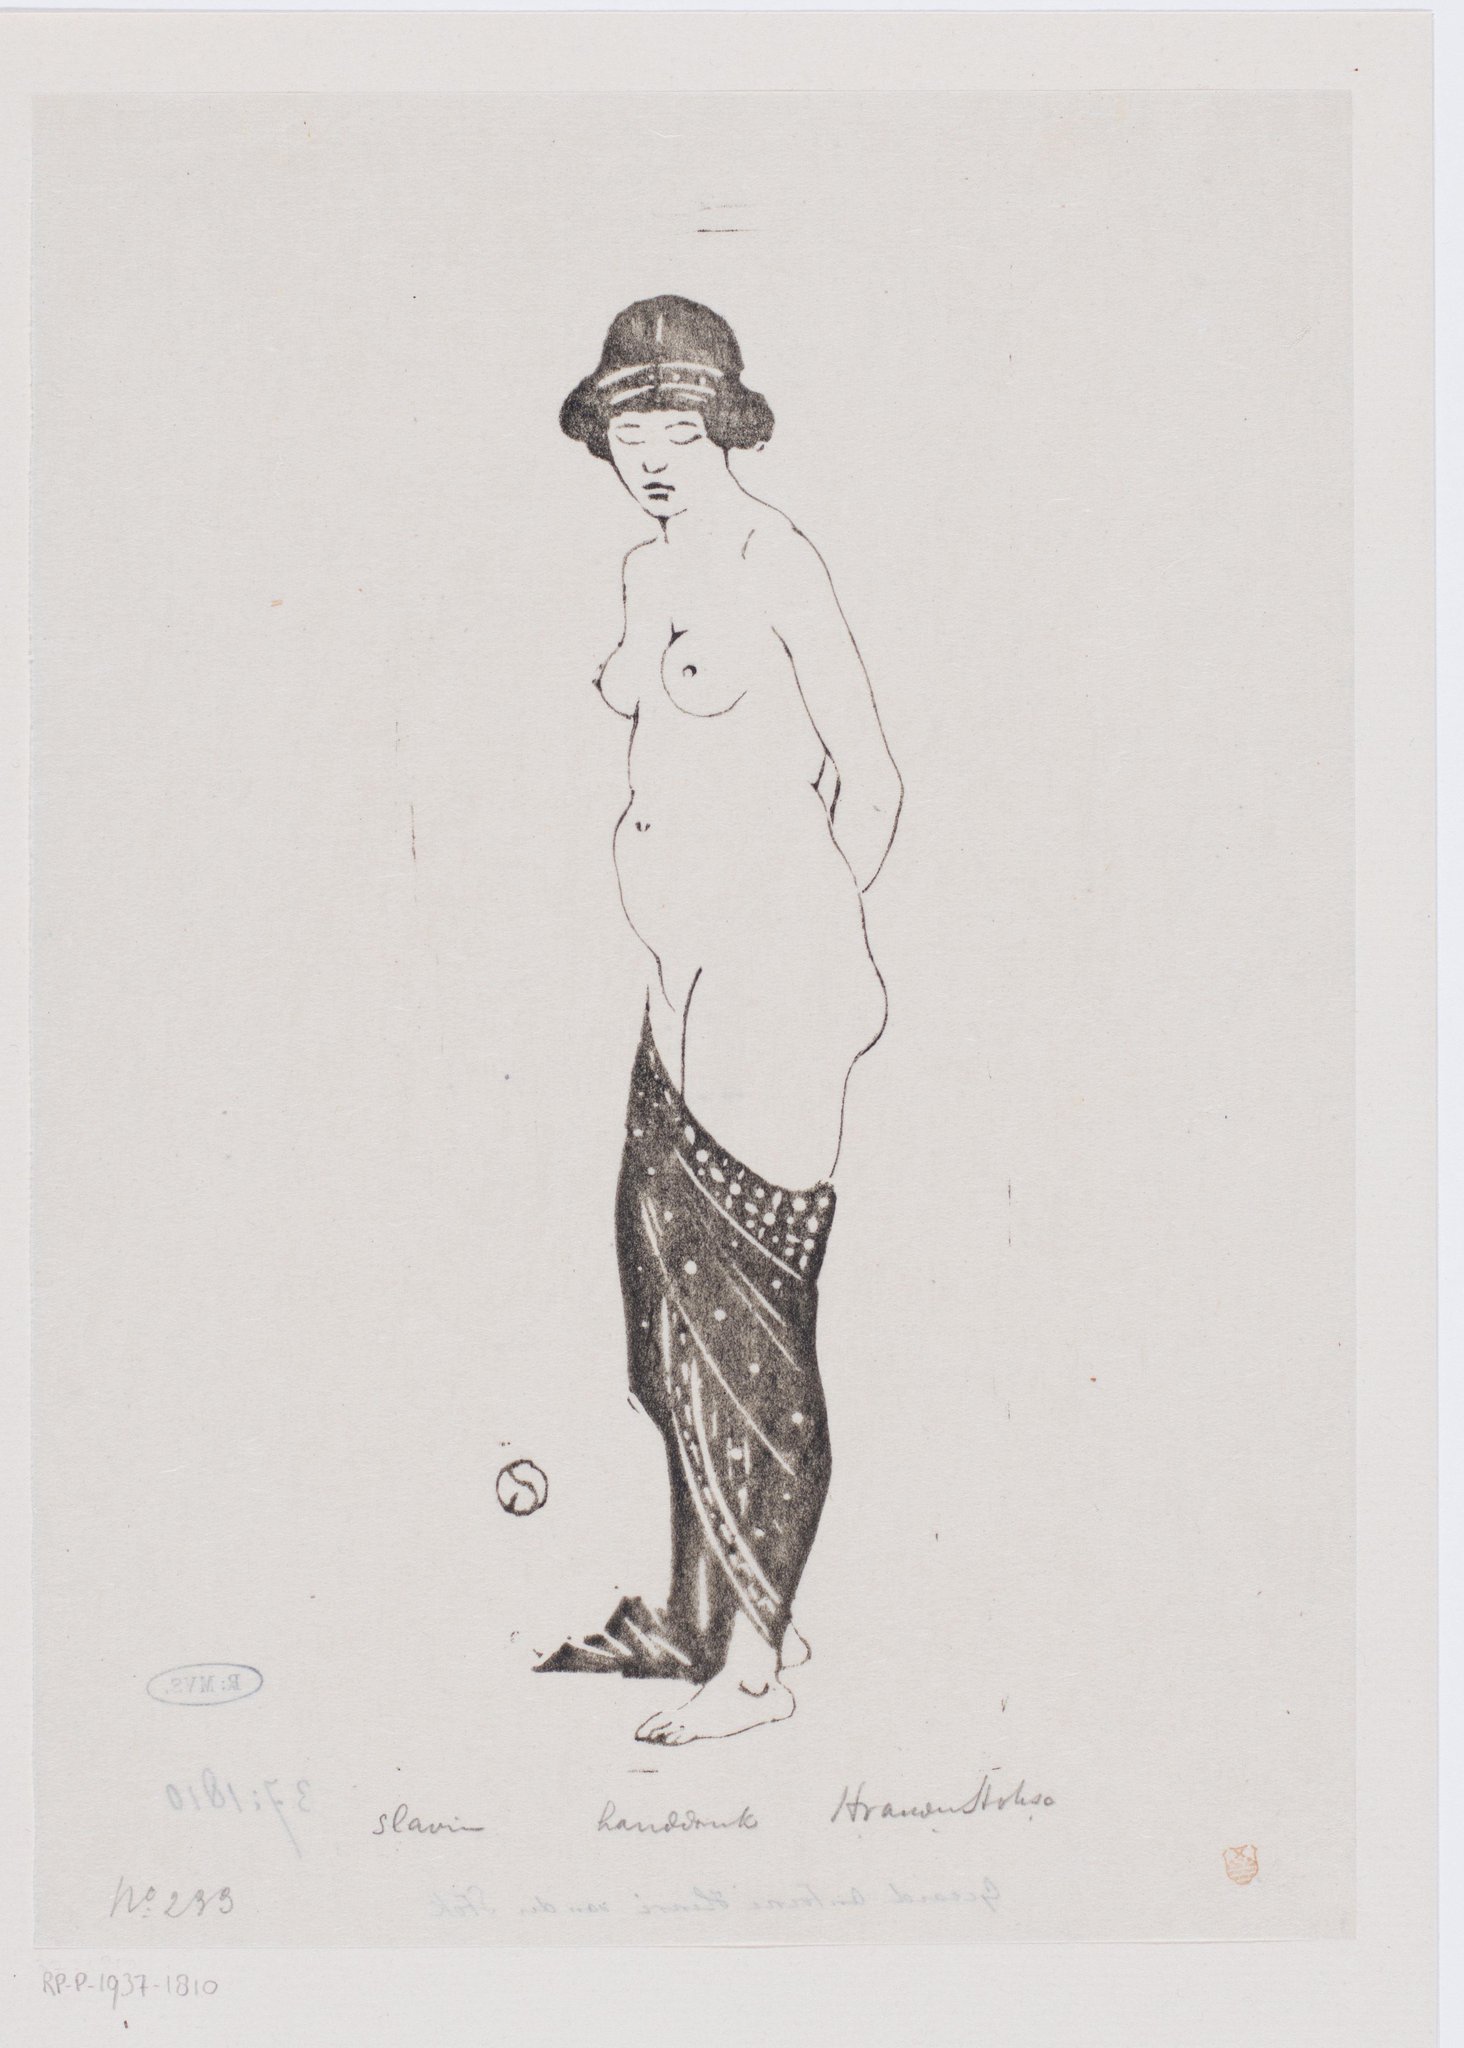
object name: print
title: Slavin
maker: henri van der stok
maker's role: print maker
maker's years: 1870-1946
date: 1880-1937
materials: paper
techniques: woodcut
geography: netherlands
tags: slavery; serfs and enslaved persons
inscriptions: collector's mark: Lugt 2760, collector's mark: Lugt 2228, number: ‘No. 233’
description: Een staande naakte vrouw. Haar omslagdoek is afgezakt tot haar onderbenen.